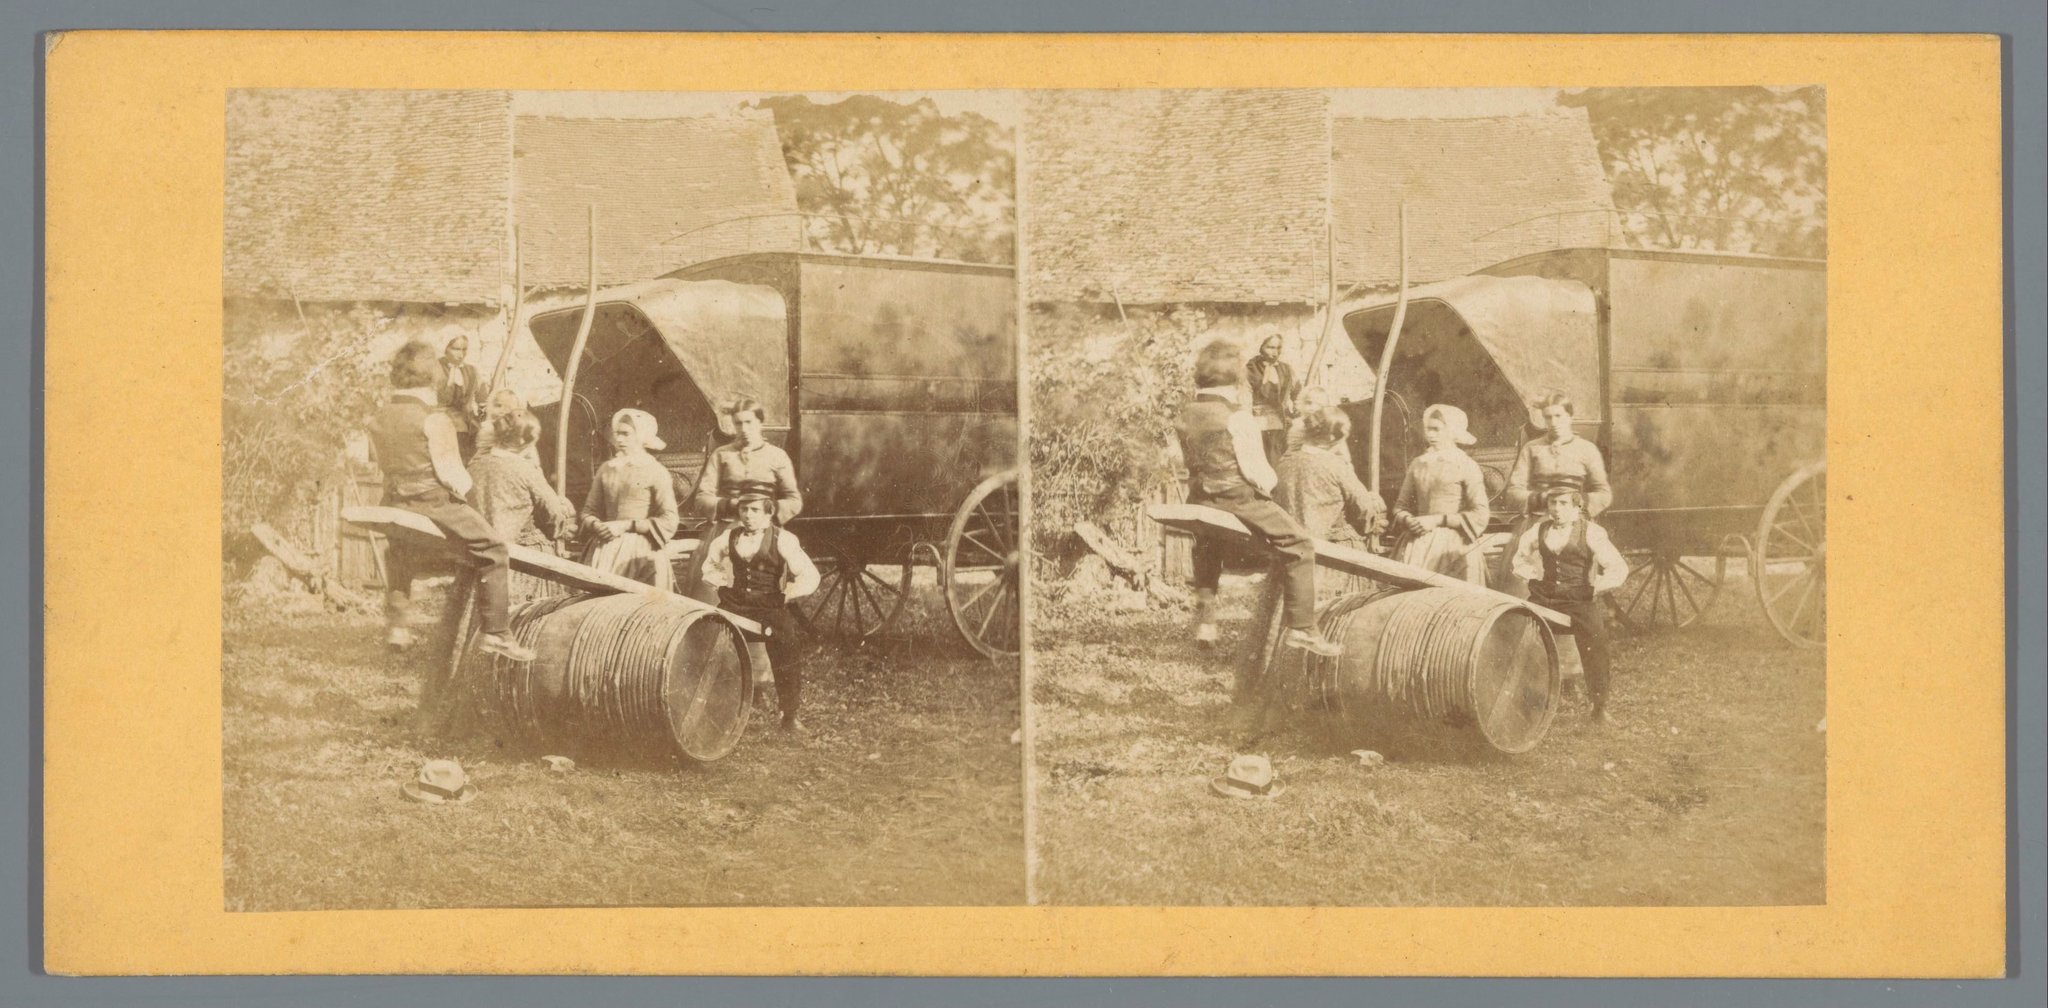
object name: stereograph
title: Kinderen op een wip en vrouwen voor een koets in een tuin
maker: Anonymous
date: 1850-1880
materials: cardboard, photographic support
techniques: albumen print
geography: europe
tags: bus, coach, seesaw, europe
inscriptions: number: ‘14 40 371’